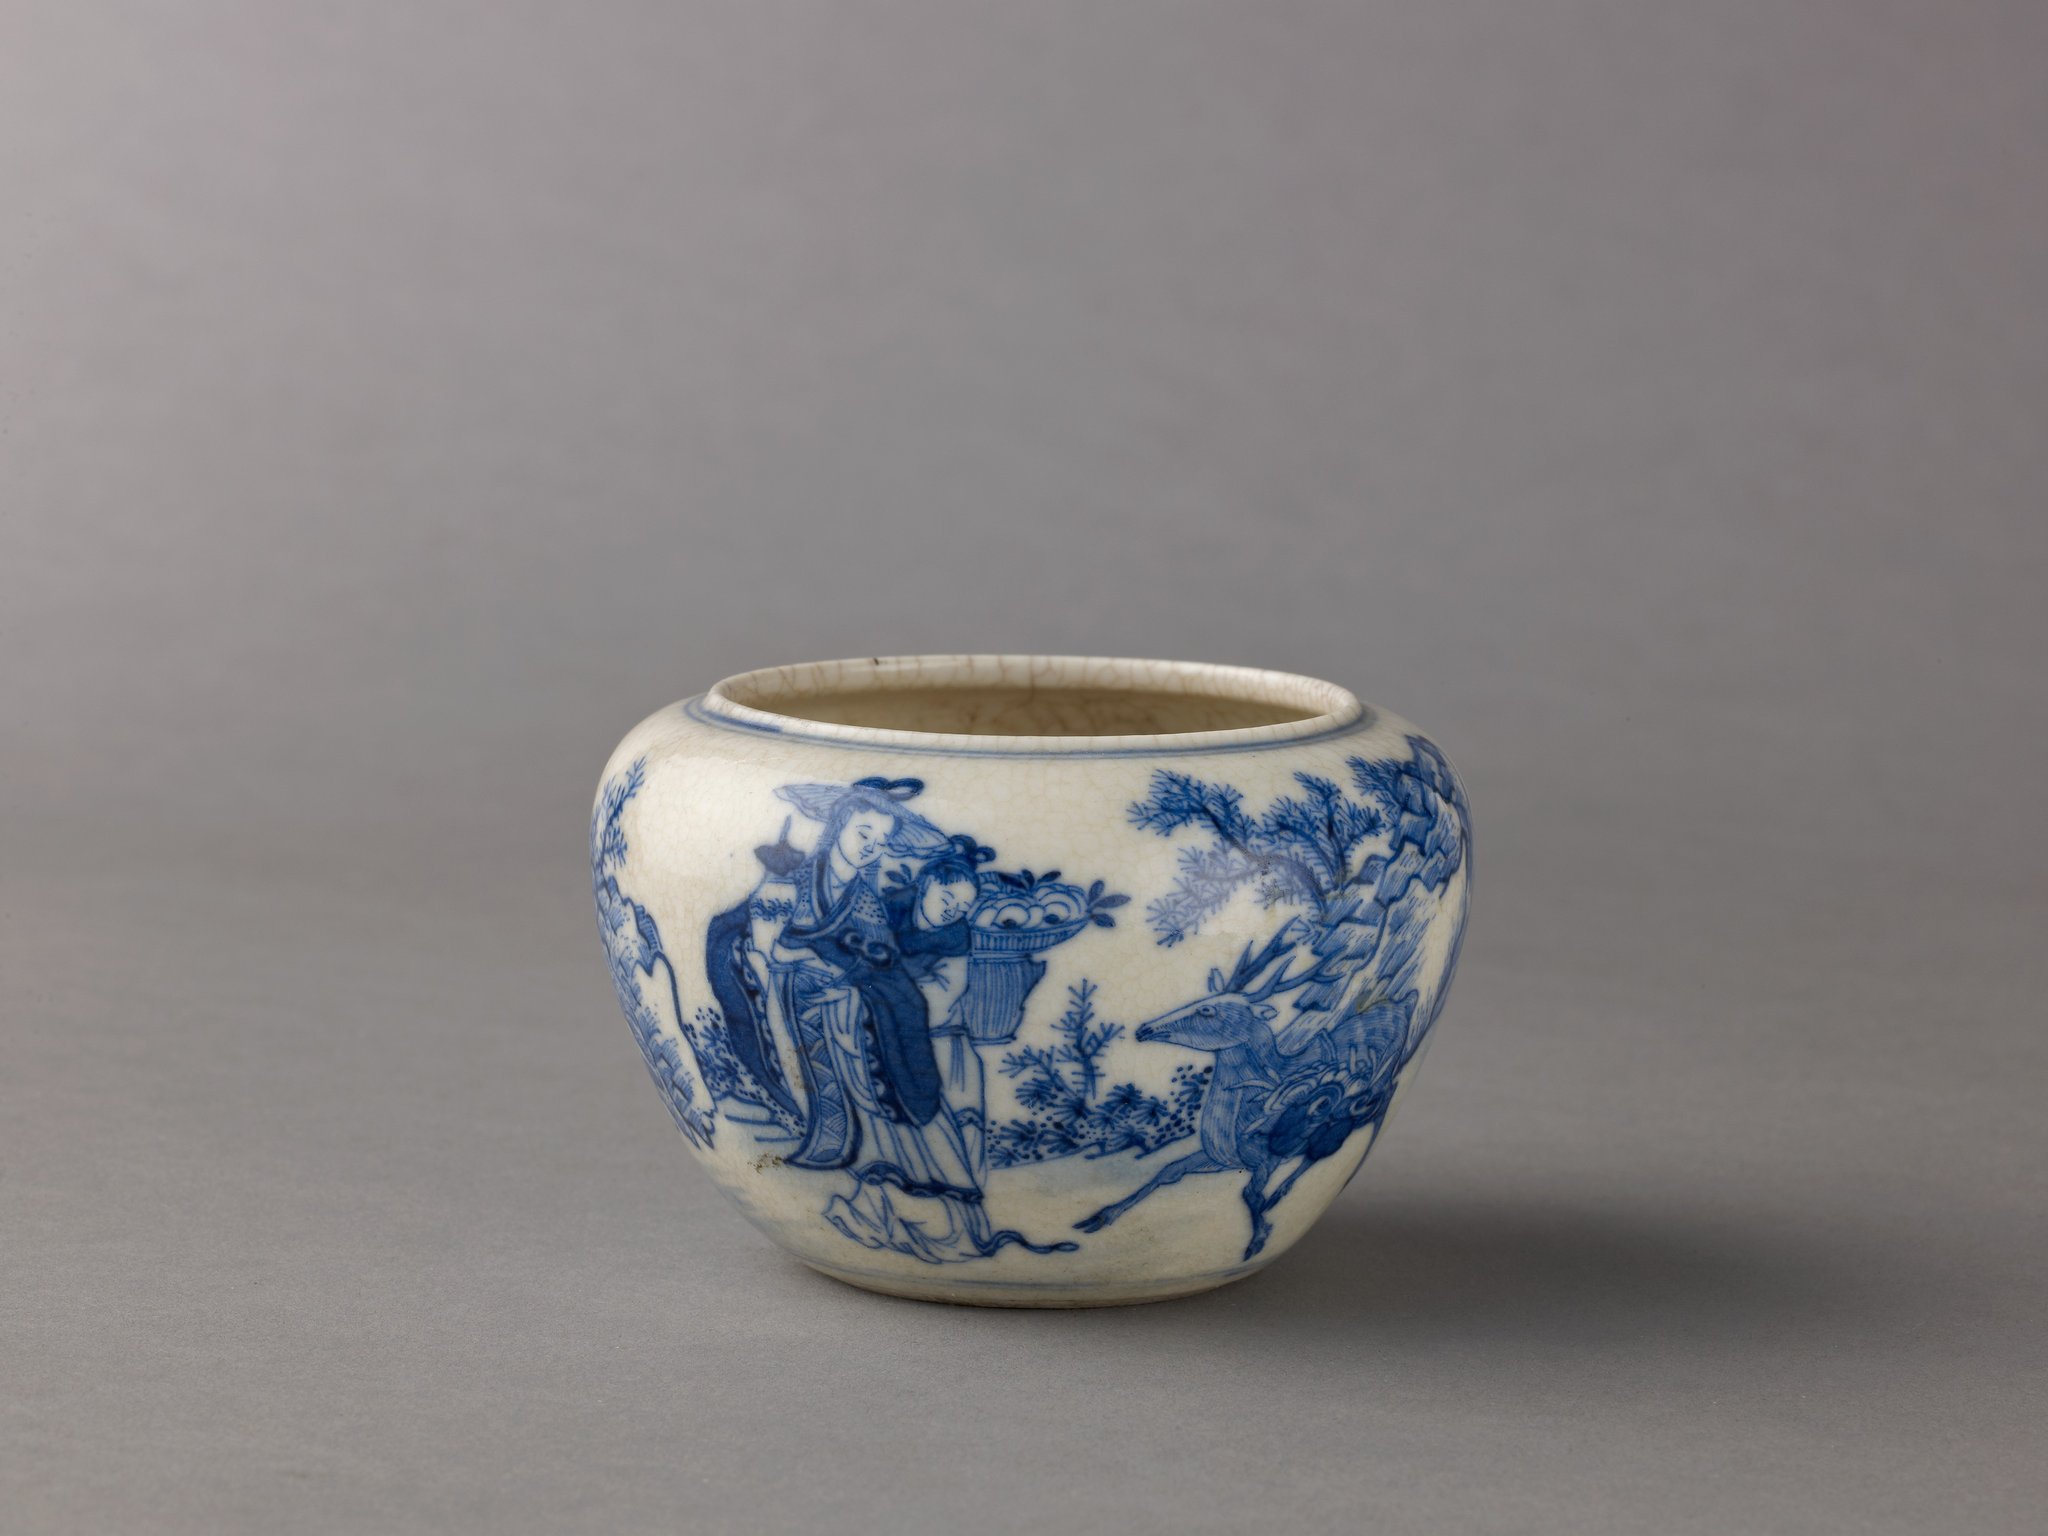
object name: water coupe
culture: chinese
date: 1701-1800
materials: paste, porcelain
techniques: painting, underglaze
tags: women,deer